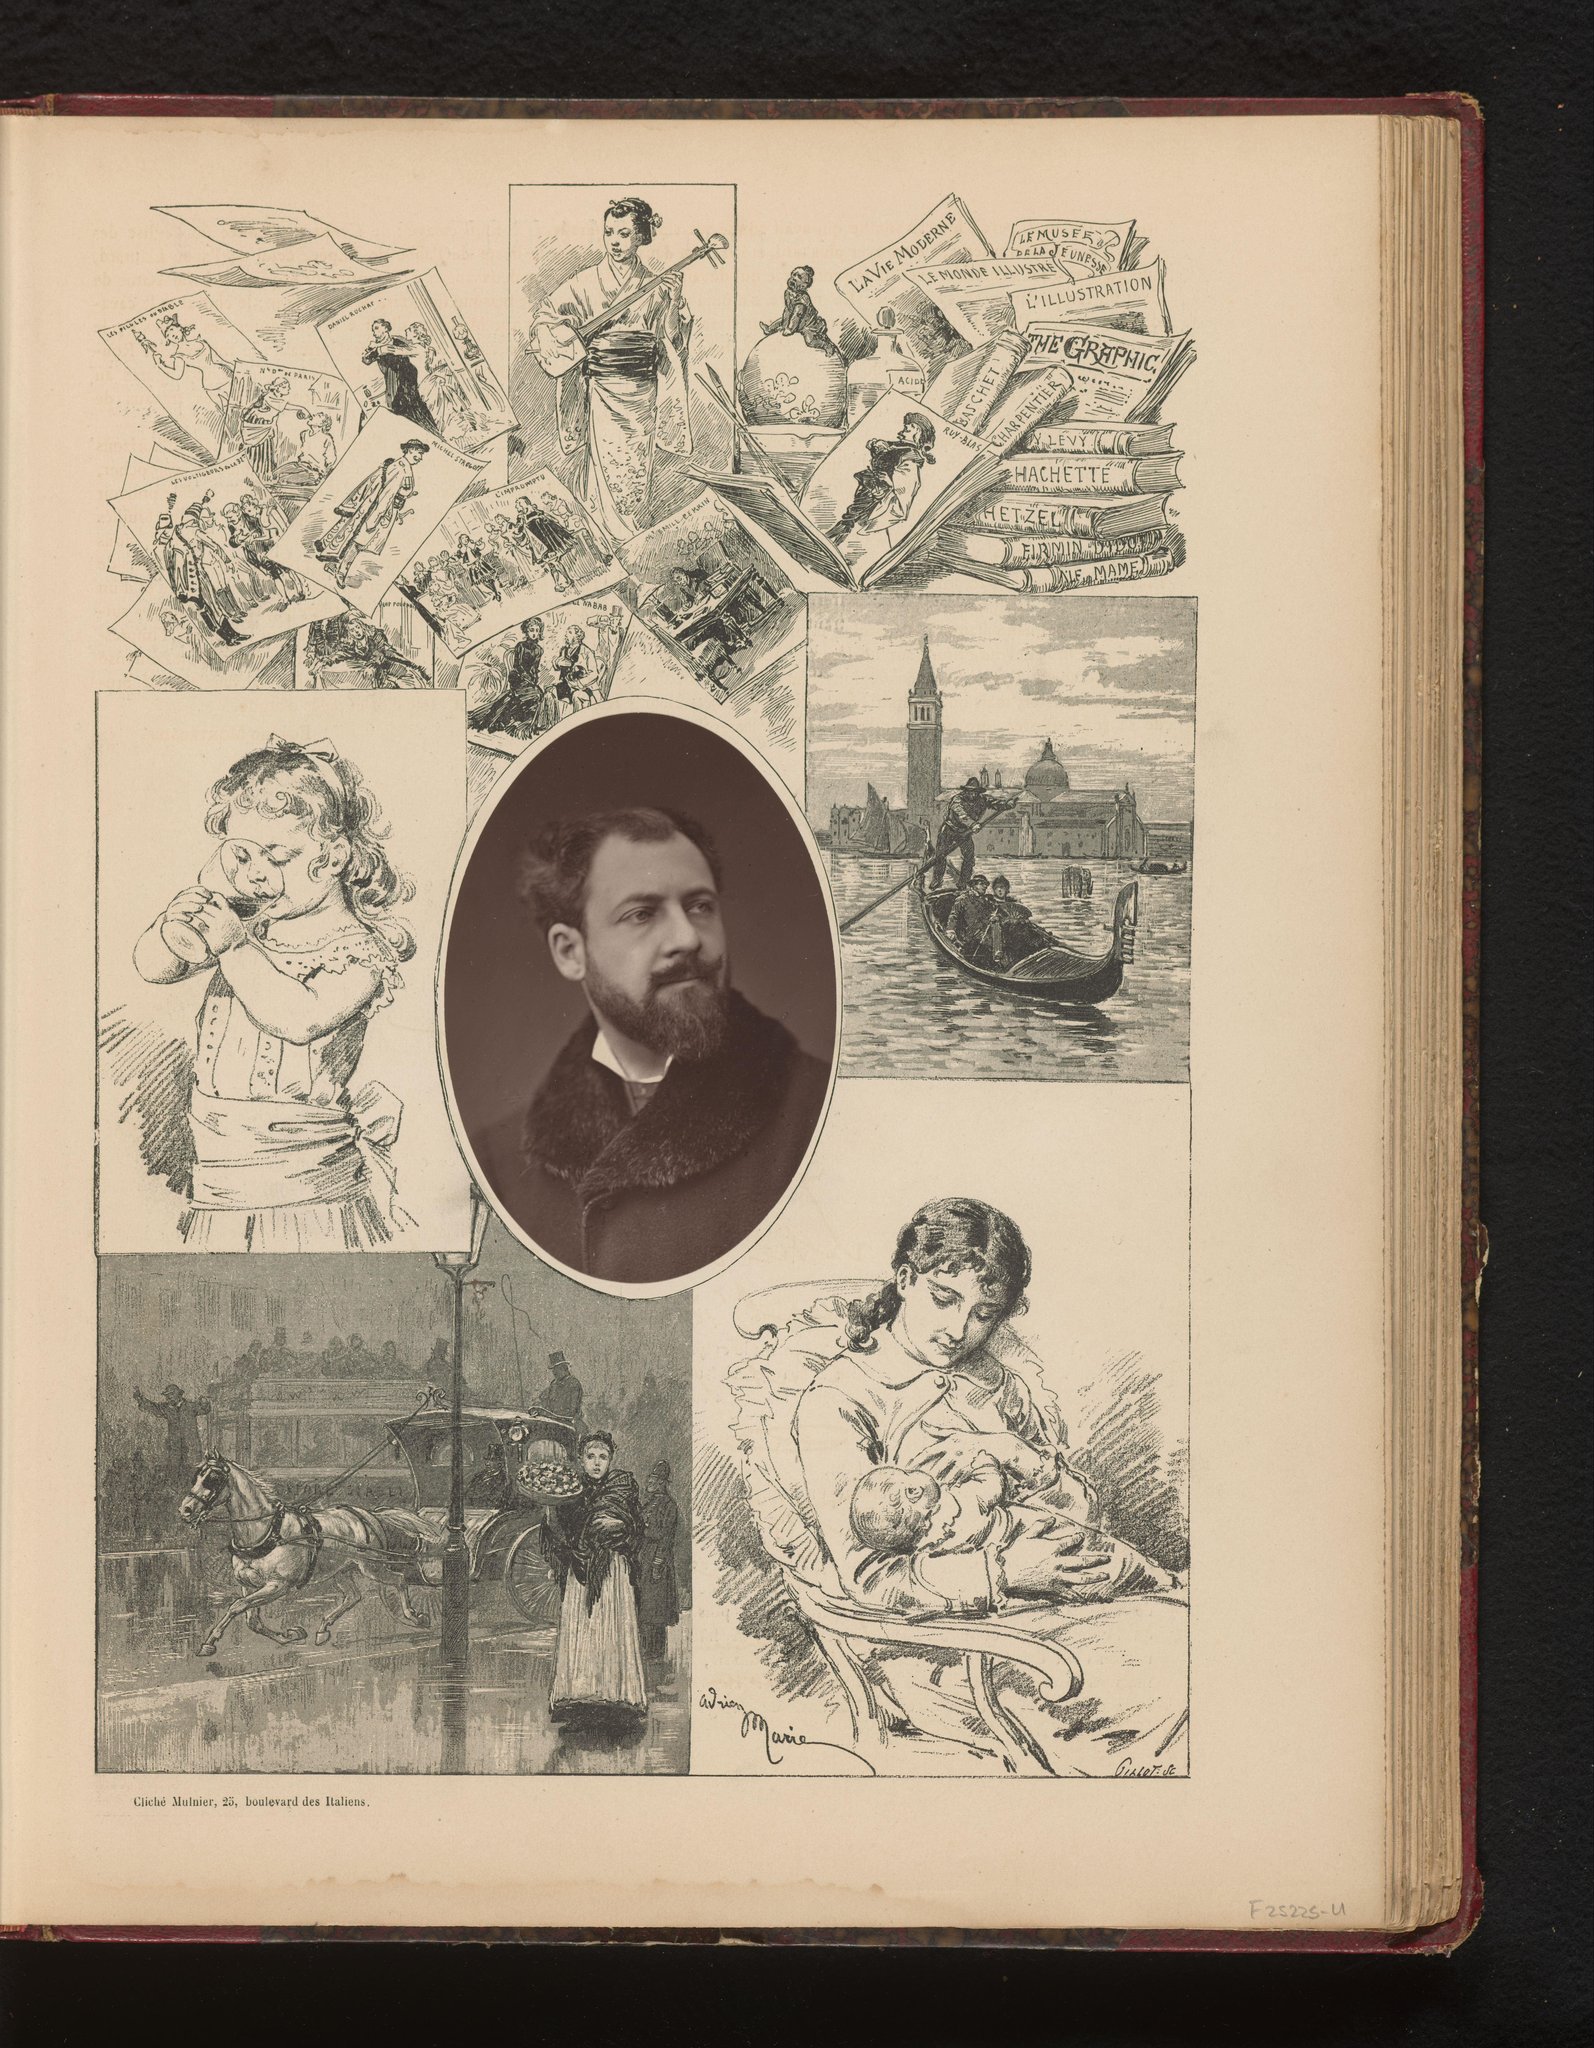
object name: page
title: Portret van Adrien Marie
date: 1876-1881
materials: paper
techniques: woodburytype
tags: draughtsman, adrien emmanuel marie, historical persons